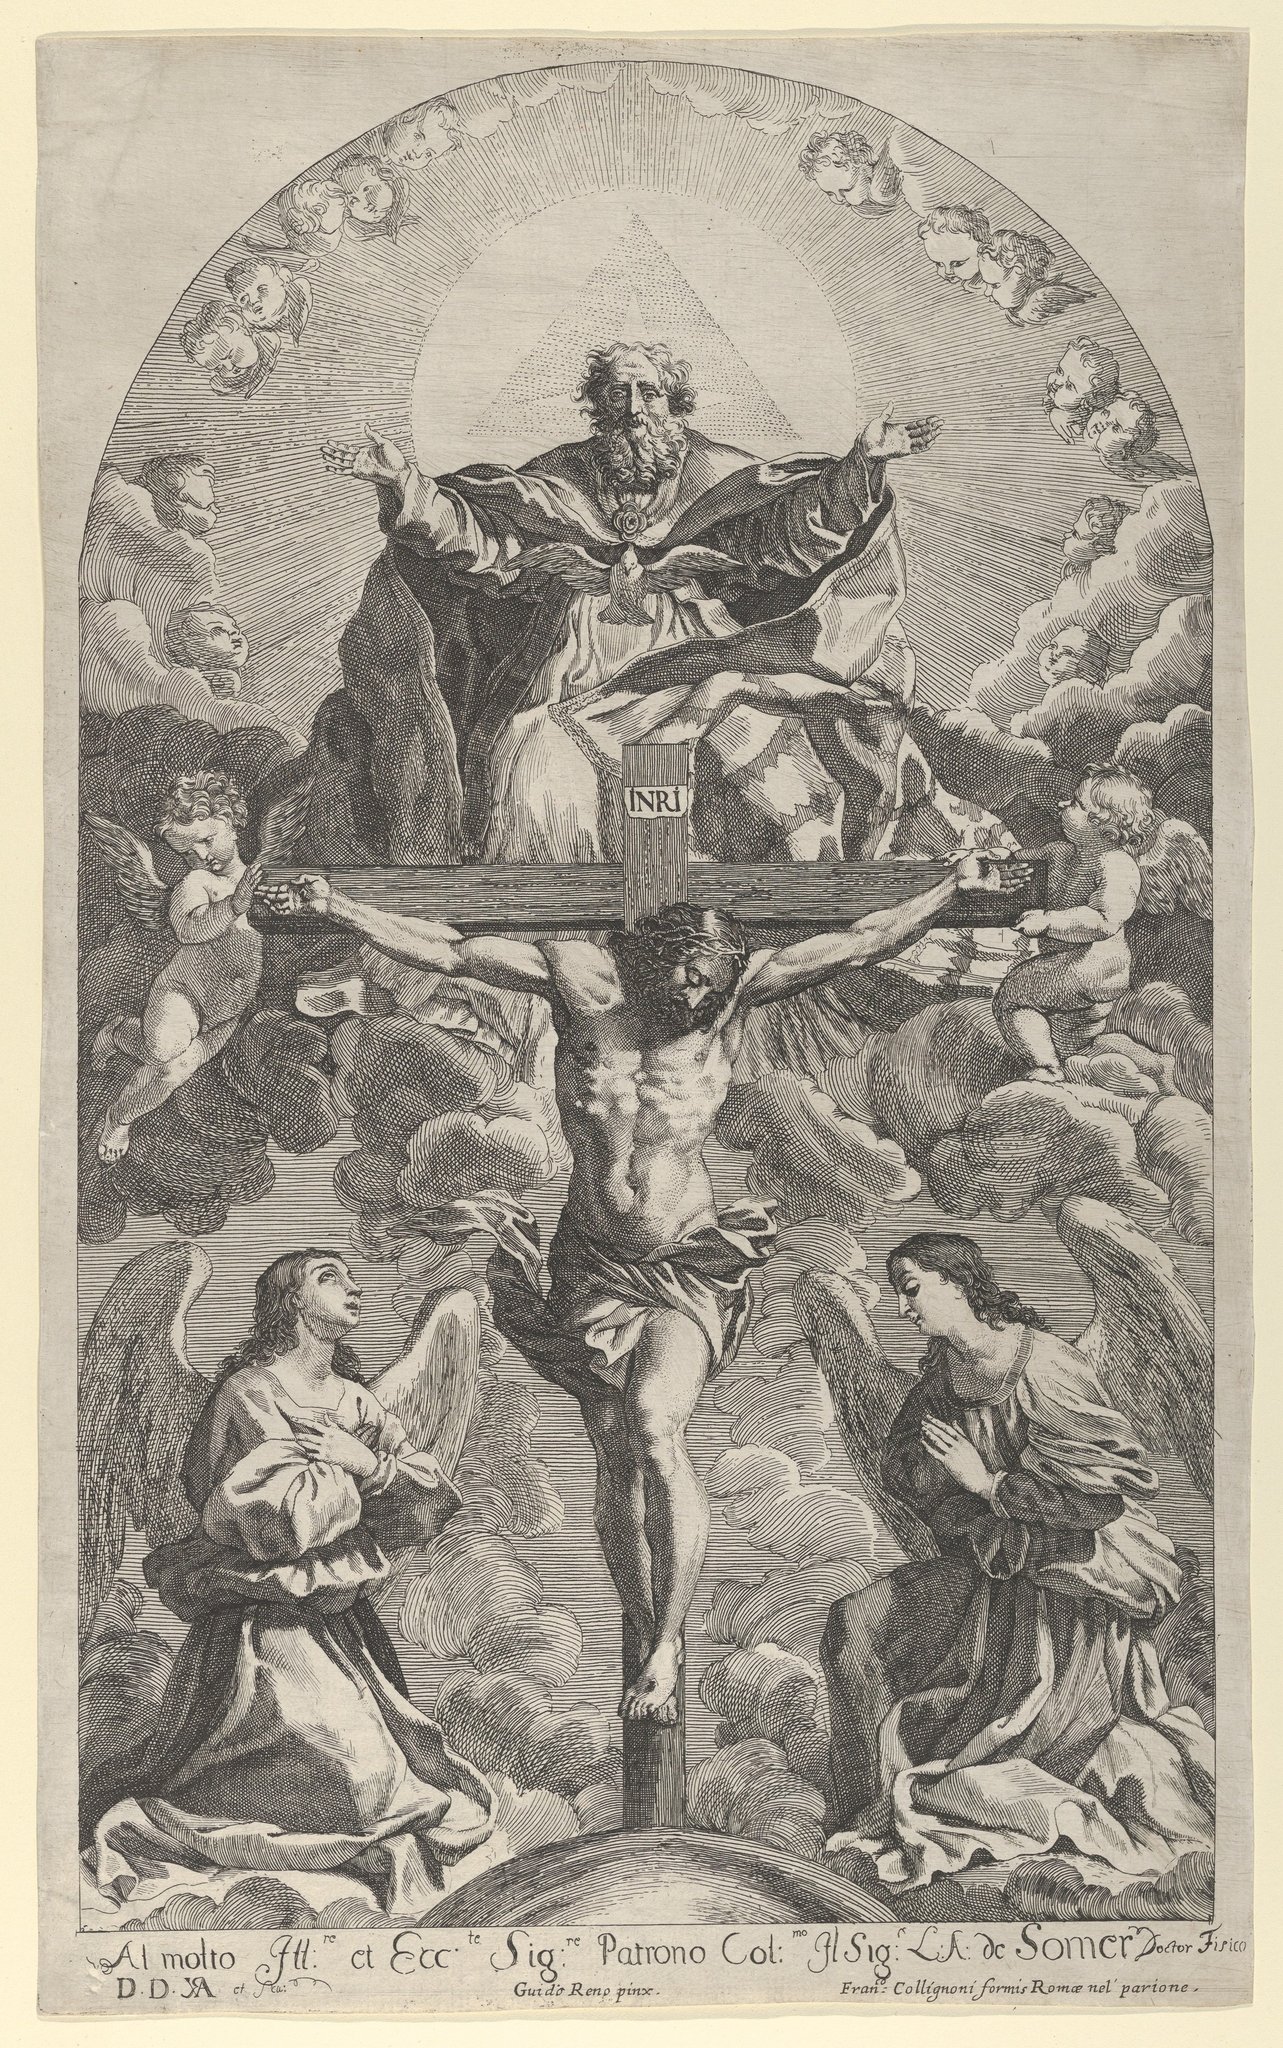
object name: print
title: The Holy Trinity; Christ on the cross flanked by two angels, the Holy Spirit as a dove and God in heaven above the cross, a rectangular composition with half-circle at the top, after Reni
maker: robert van audenaerde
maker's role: artist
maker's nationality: flemish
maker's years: 1663-1743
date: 1683-1687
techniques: etching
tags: doves,angels,christ,cross,gods